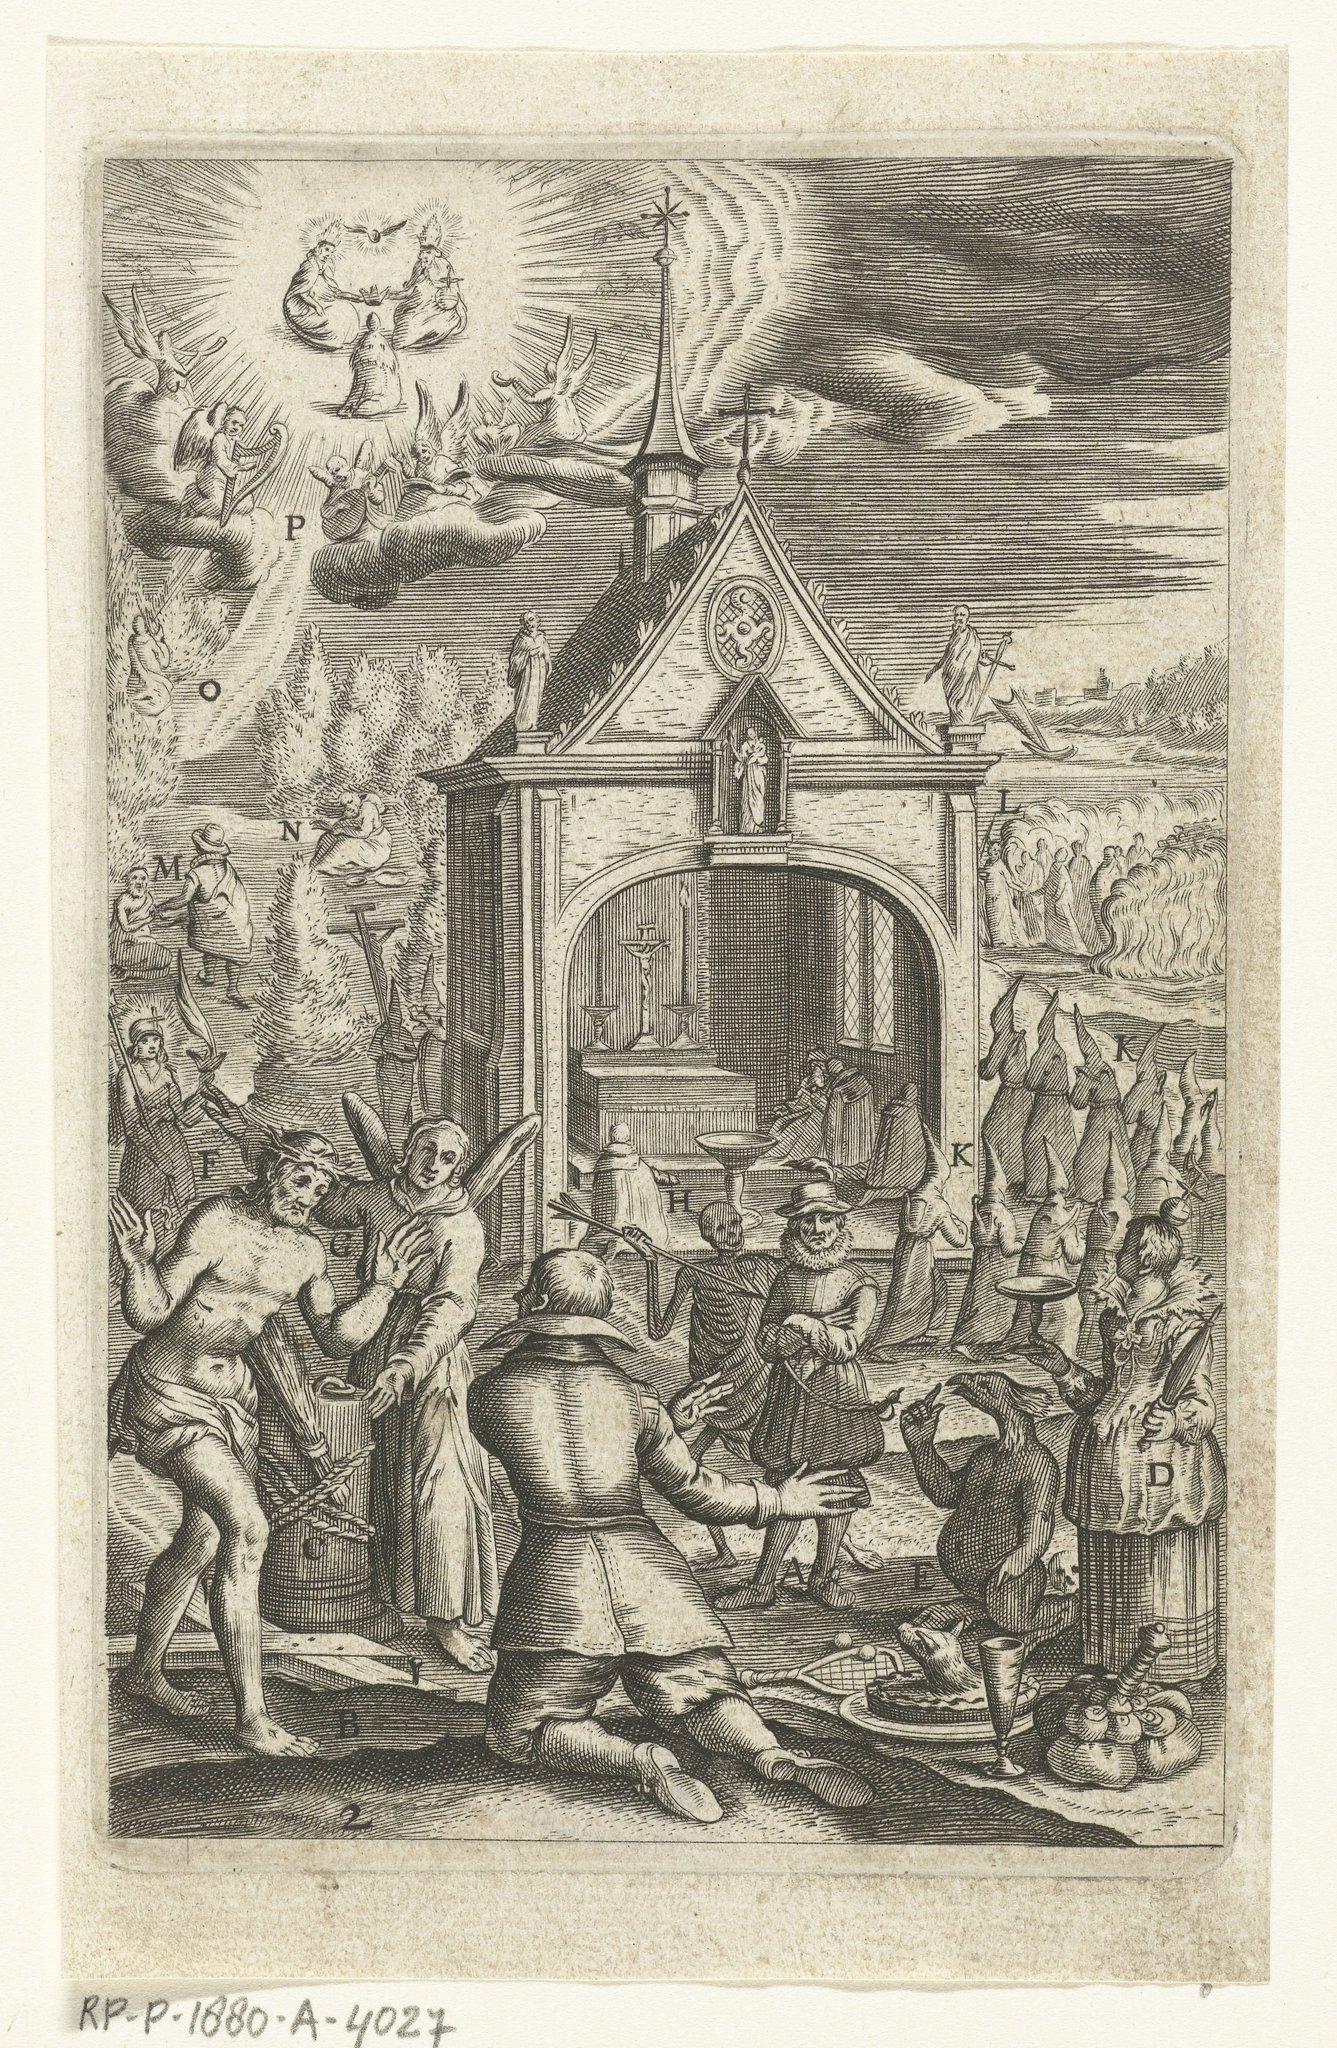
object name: book illustration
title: Embleem met man die afstand doet van zijn aardse bezittingen en zich bekeert tot het christelijke geloof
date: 1620-1623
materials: paper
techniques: engraving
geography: antwerp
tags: the life of man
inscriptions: collector's mark: Lugt 2228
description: Een man knielt voor Christus die hem zijn wonden toont. De man maakt een armgebaar waarmee hij afstand doet van zijn aardse bezittingen. In het landschap zijn voorbeelden weergegeven van christenen die zich op de juiste manier wijden aan het geloof zoals geestelijken of een kluizenaar.